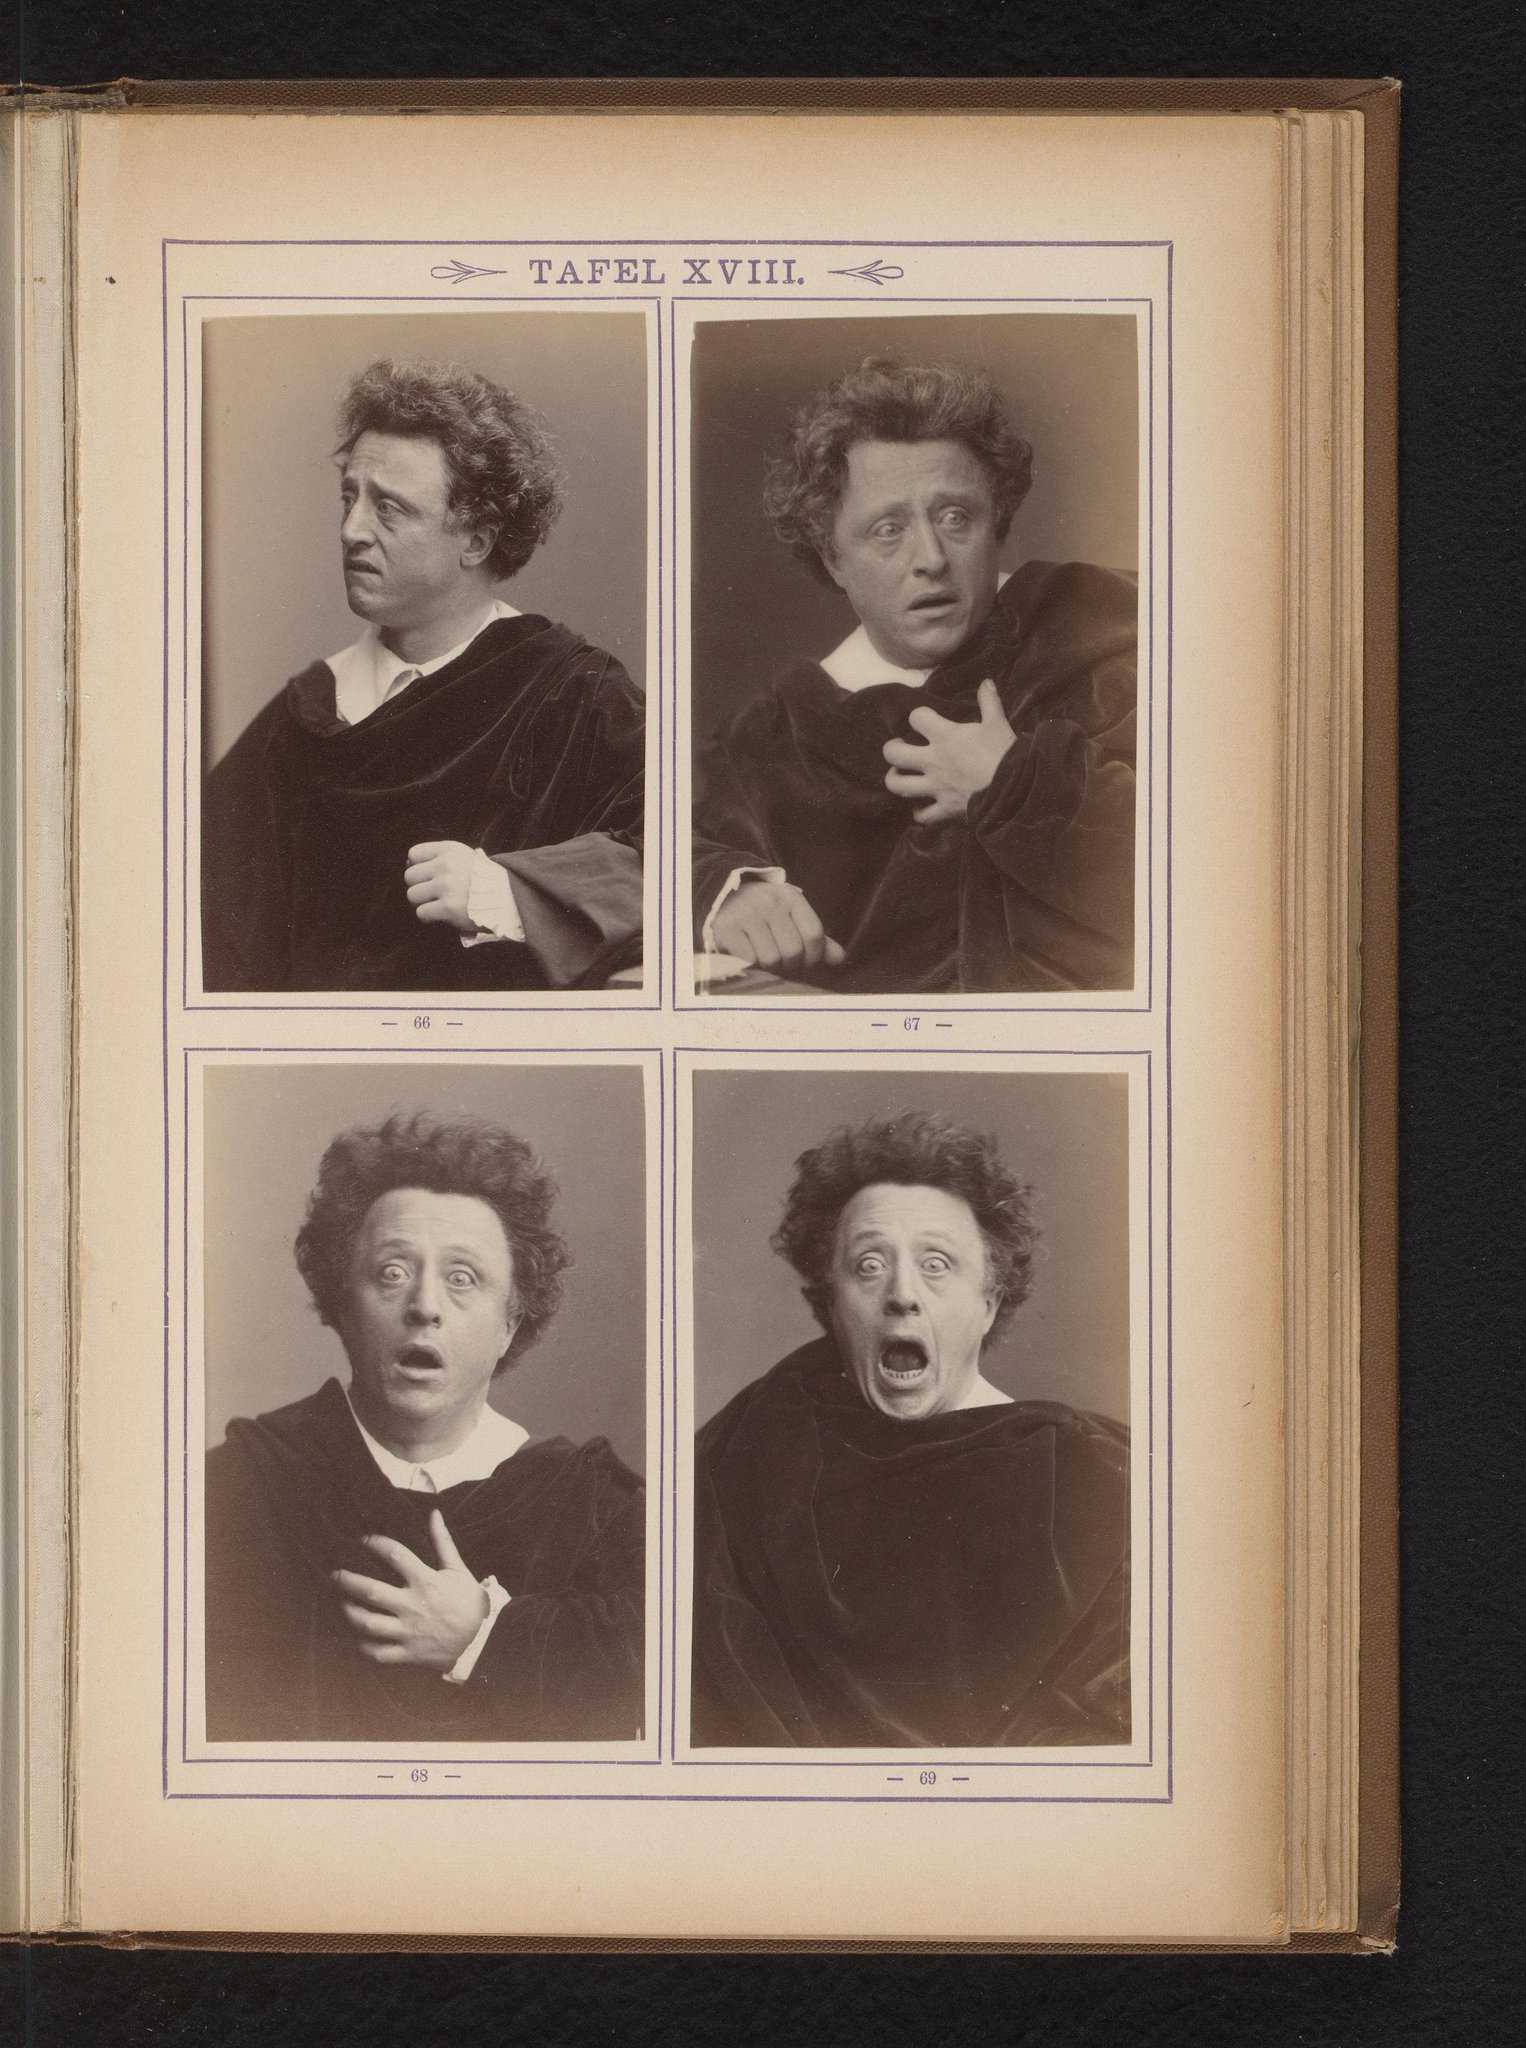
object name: photograph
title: Vier portretten van een man met gezichtsuitdrukkingen van bezorgdheid, angst, schrik en ontzetting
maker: nicola tonger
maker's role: fotograaf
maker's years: 1846-1917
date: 1881-1886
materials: paper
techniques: albumen print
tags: morphology of facial expression, physiognomy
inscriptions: number: ‘TAFEL XVIII.’, number: ‘66 - 69’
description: Foto op vijfendertigste ongenummerde pagina na pagina 6.